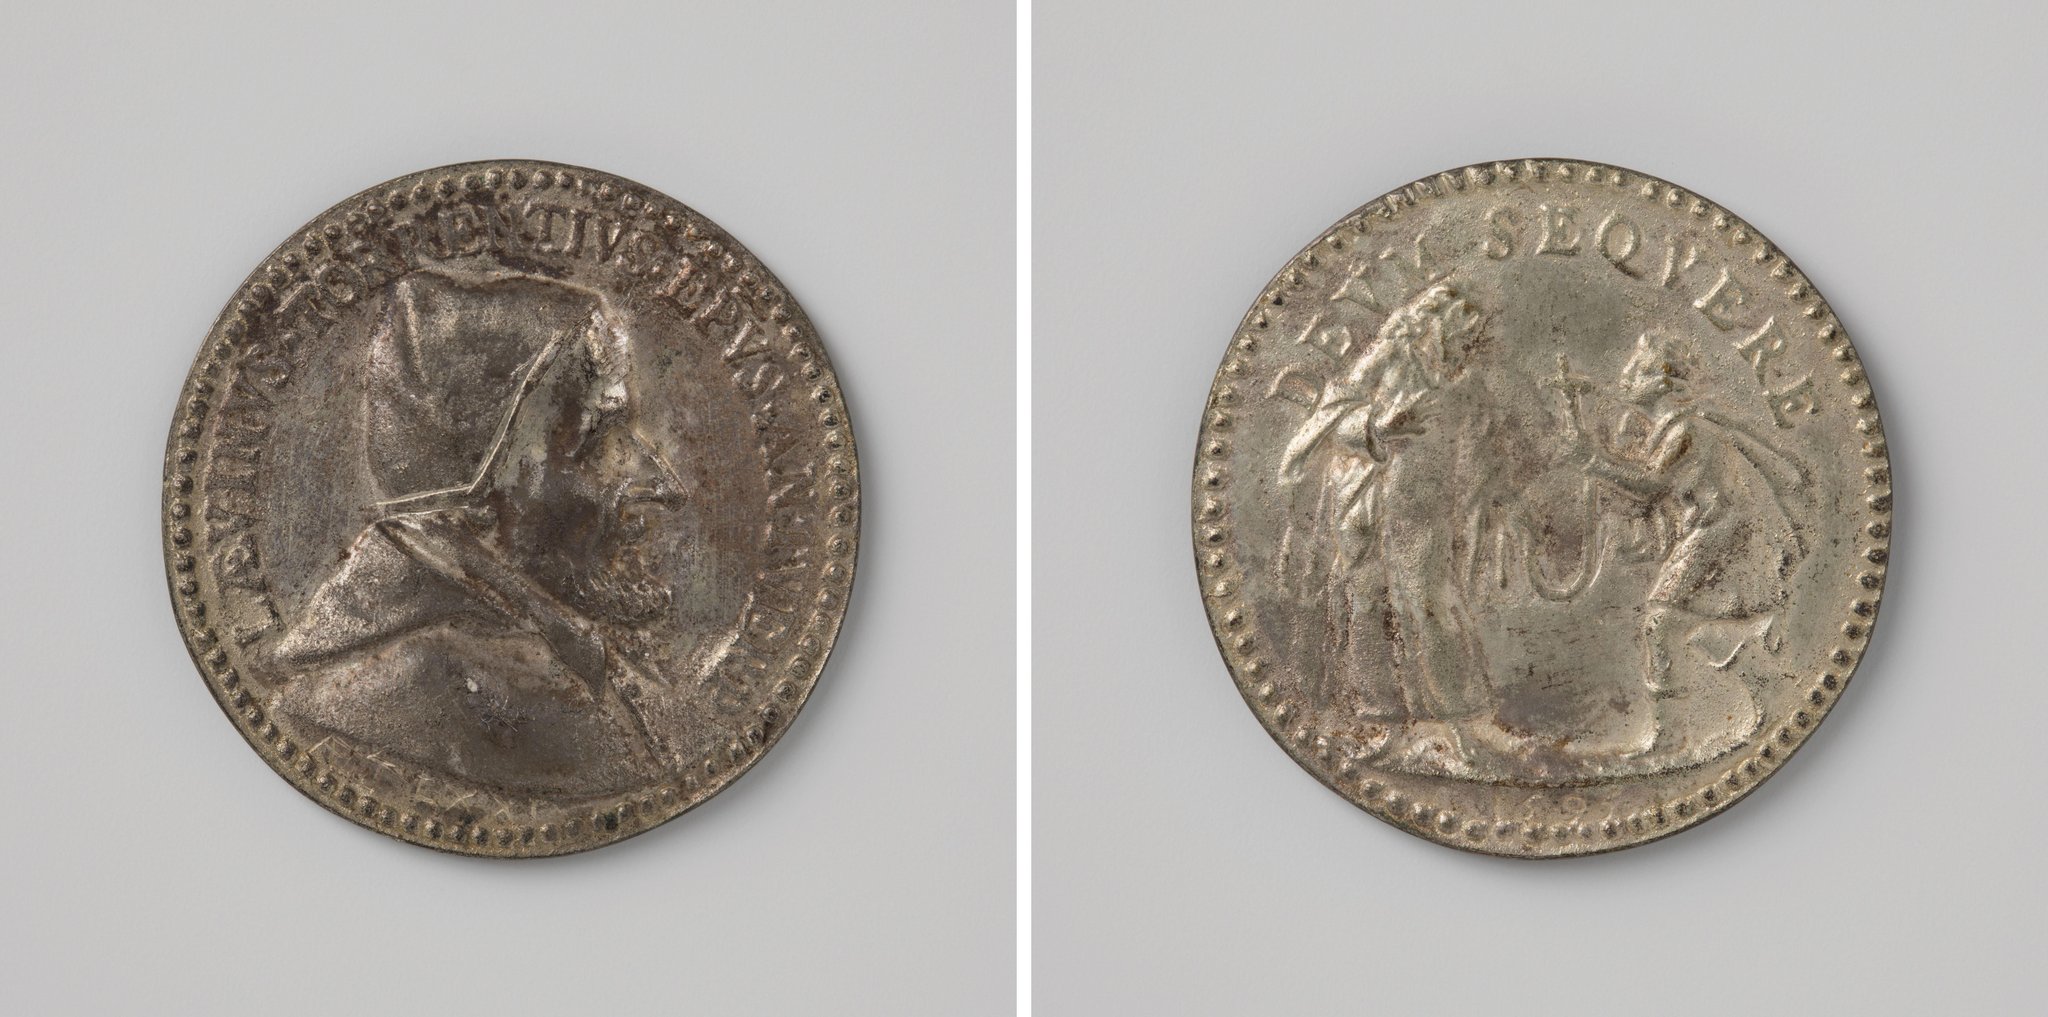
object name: history medal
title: Overlijden van Laevinus Torrentius, bisschop van Antwerpen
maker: Anonymous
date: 1595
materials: silver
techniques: casting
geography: belgium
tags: ghent, laevinus torrentius, antwerp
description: Zilveren penning. Voorzijde: borststuk man binnen omschrift. Keerzijde: Christus leidt met behulp van touw een jongeman die kruis in hand houdt binnen omschrift; afsnede: jaartal